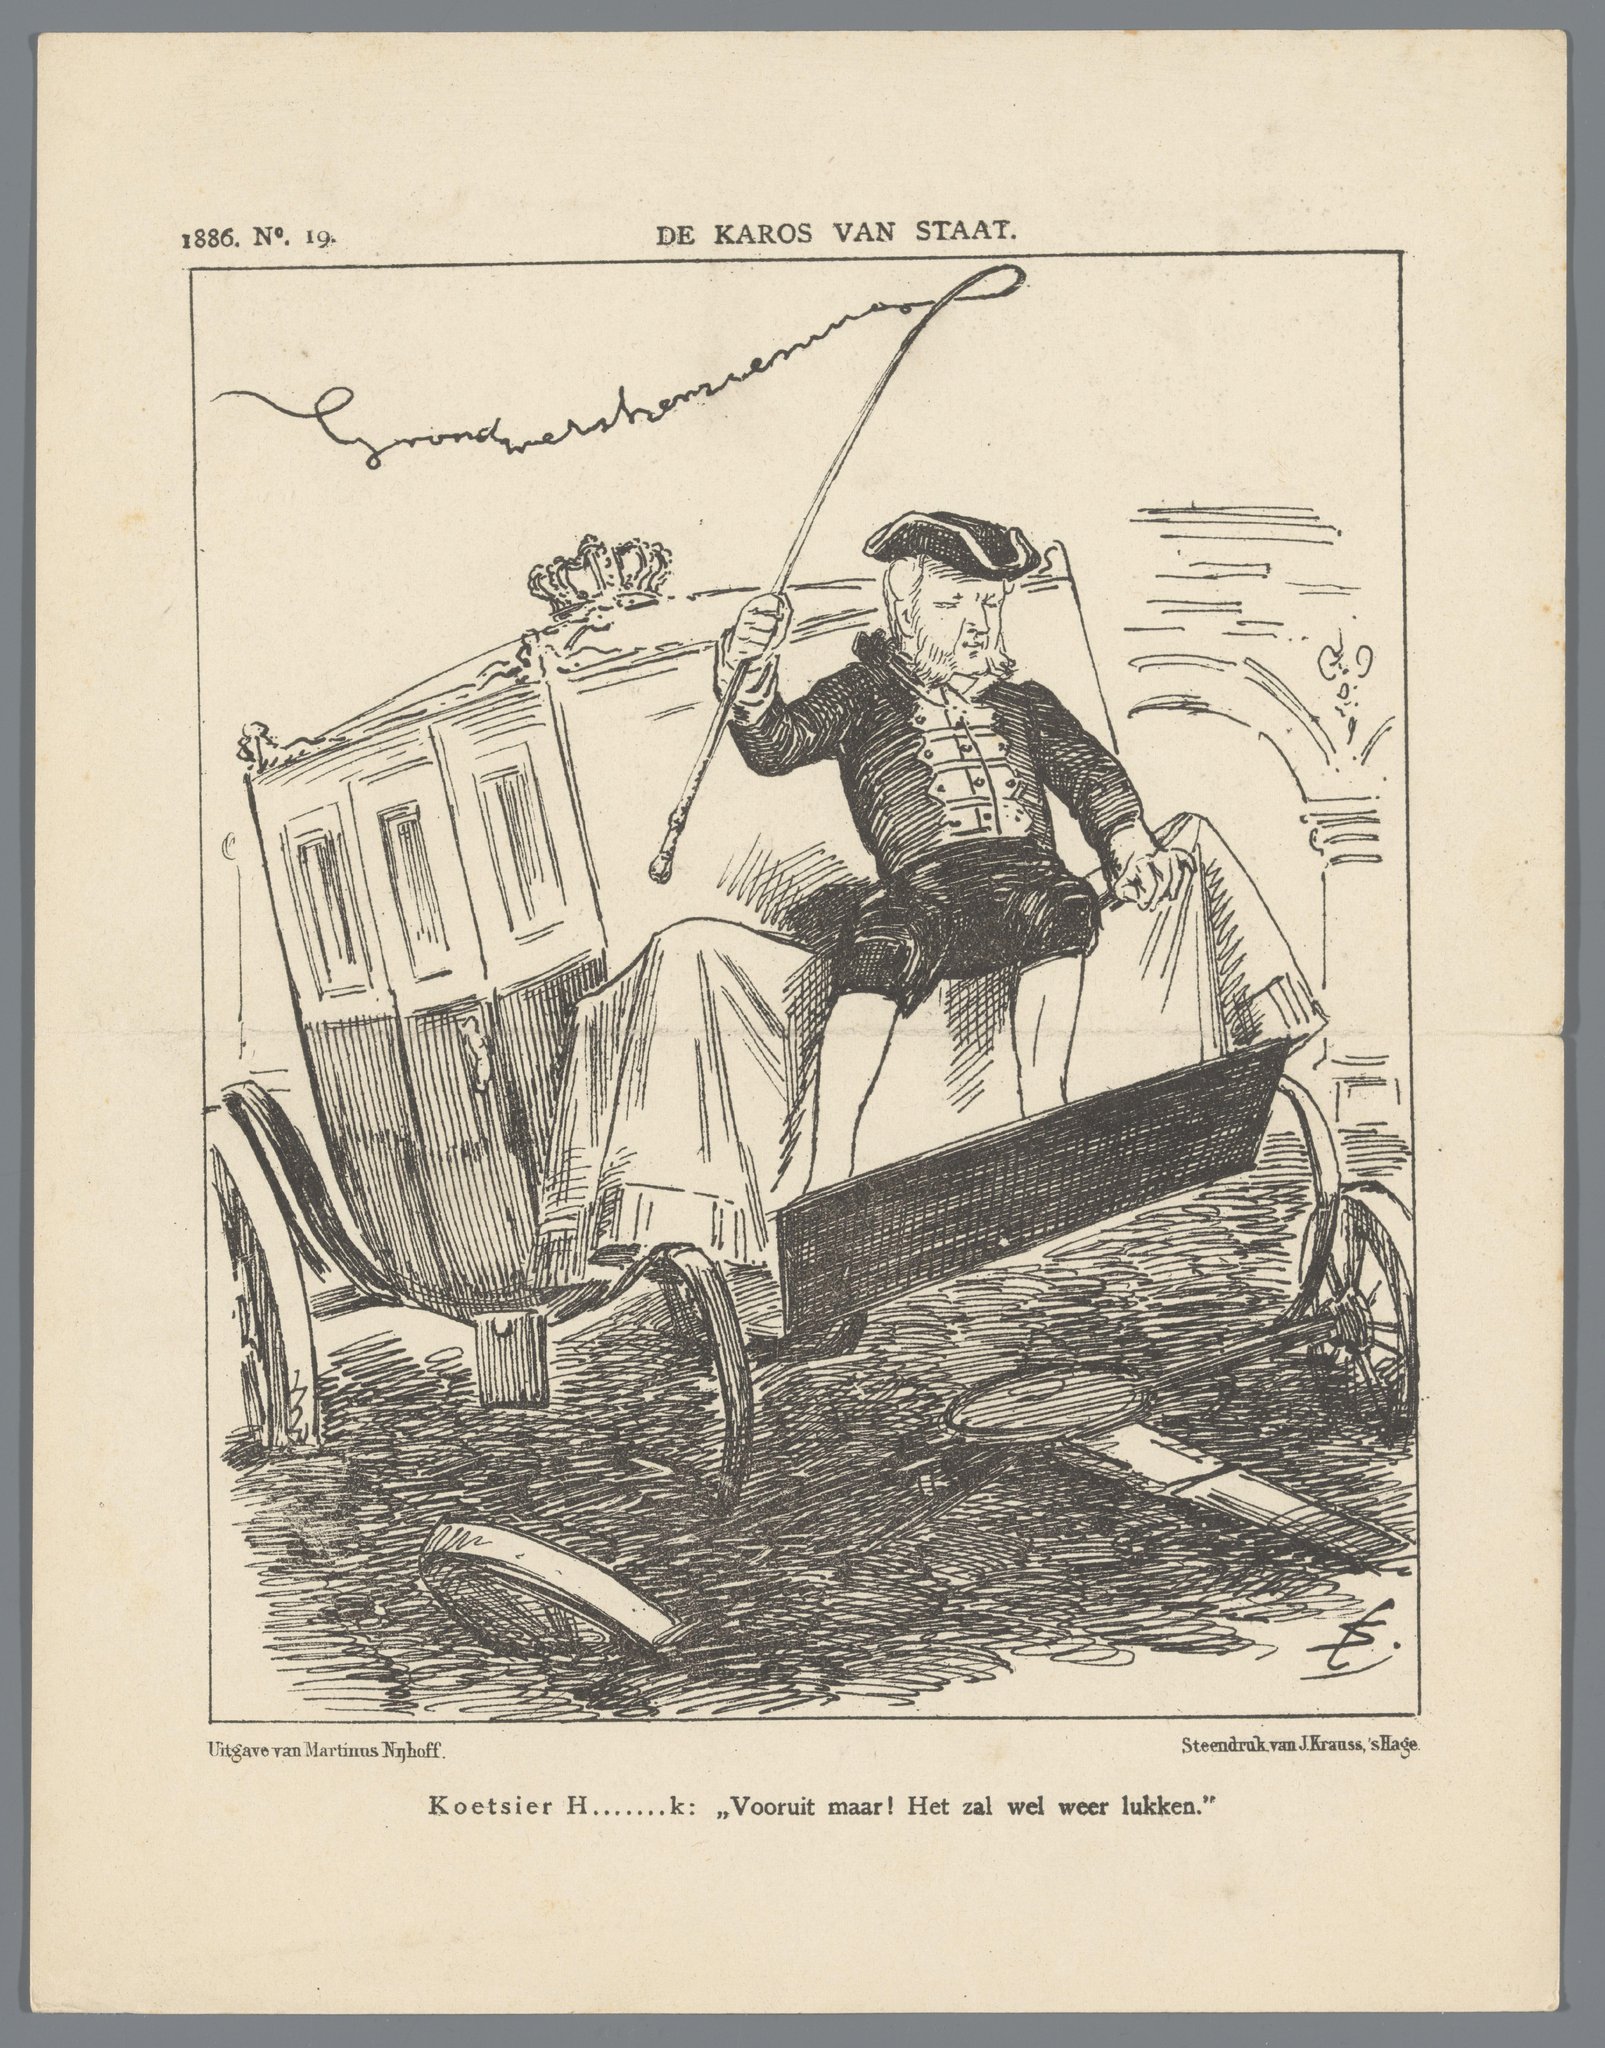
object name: print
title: Spotprent met minister Heemskerk als koetsier, 1886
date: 1886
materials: paper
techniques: lithograph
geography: the hague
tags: tweede kamerlid, minister van staat, minister van binnenlandse zaken, minister van justitie, jan heemskerk azn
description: Spotprent met minister Heemskerk als koetsier, 1886. Plaat verschenen bij het weekblad De Nederlandsche Spectator, nr. 19, 1886.